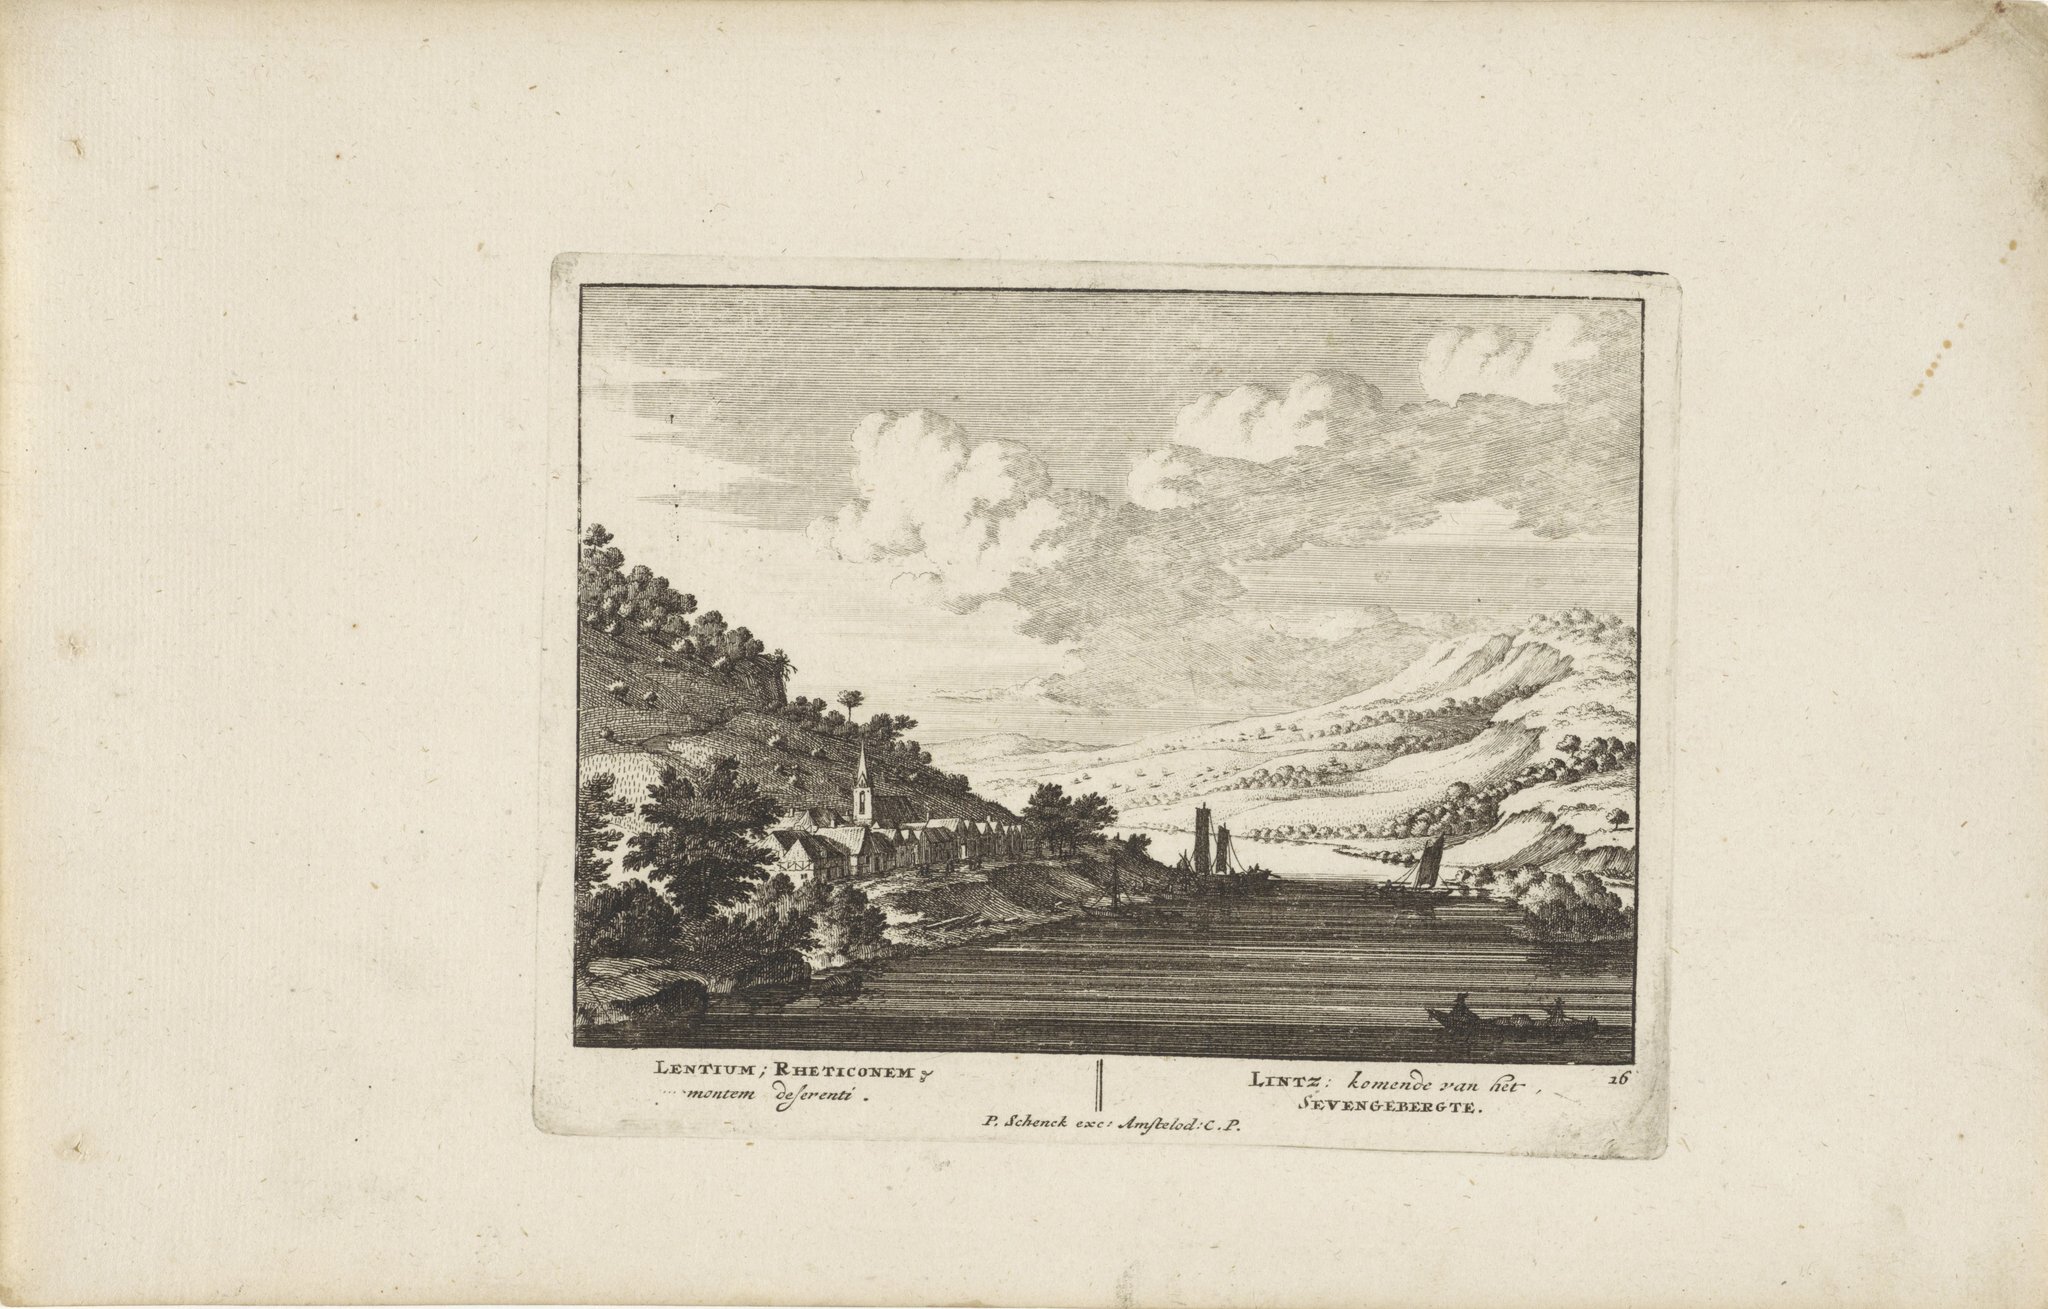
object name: print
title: Linz aan de Rijn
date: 1694-1697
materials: paper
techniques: etching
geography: amsterdam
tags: river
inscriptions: collector's mark: Lugt 2228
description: Linz aan de Rijn. Prent uit een serie van 71 prenten met Rijnlandschappen, gezichten op vorstelijke paleizen en stadsgezichten uit Den Haag en Amsterdam.